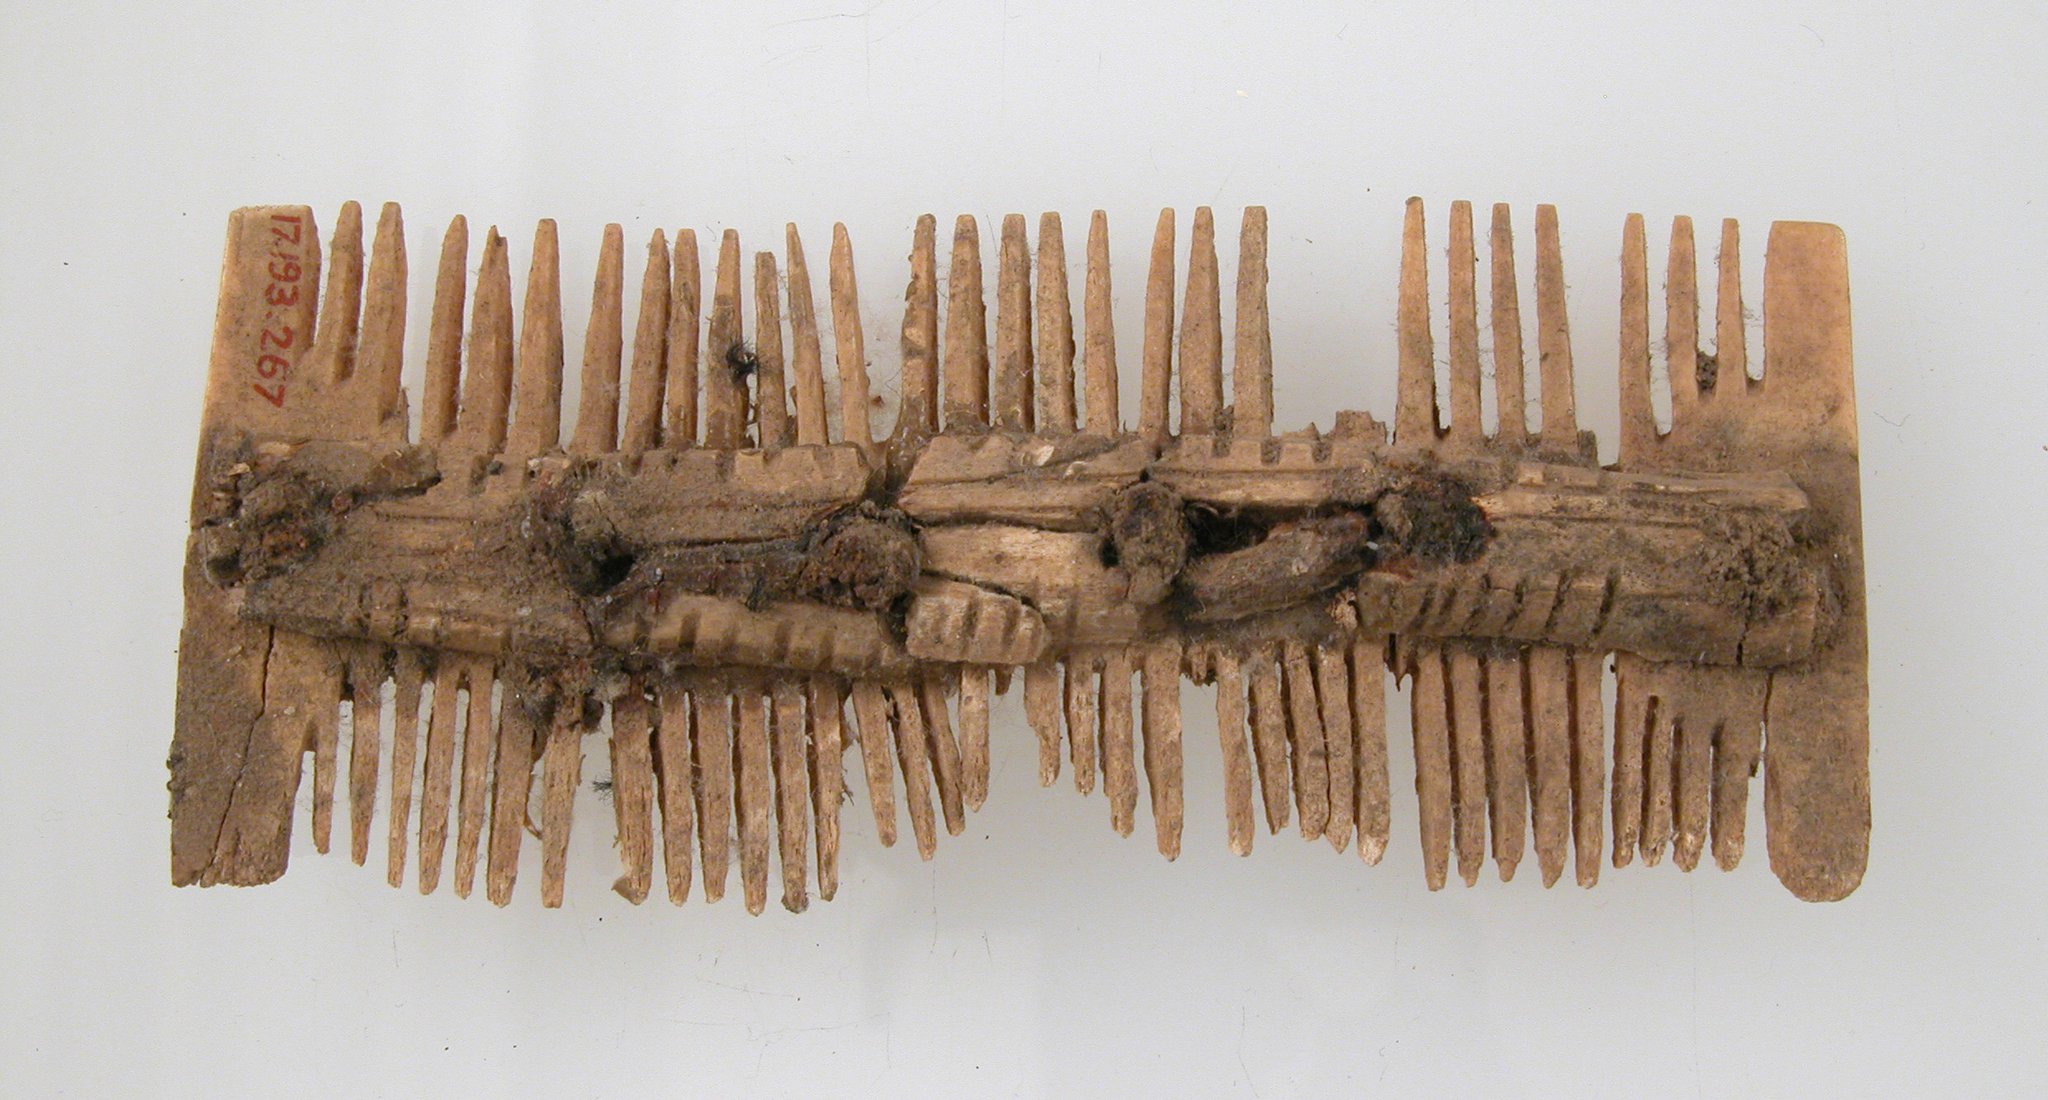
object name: comb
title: Double-Sided Comb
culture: frankish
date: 601-700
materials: bone, iron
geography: germany